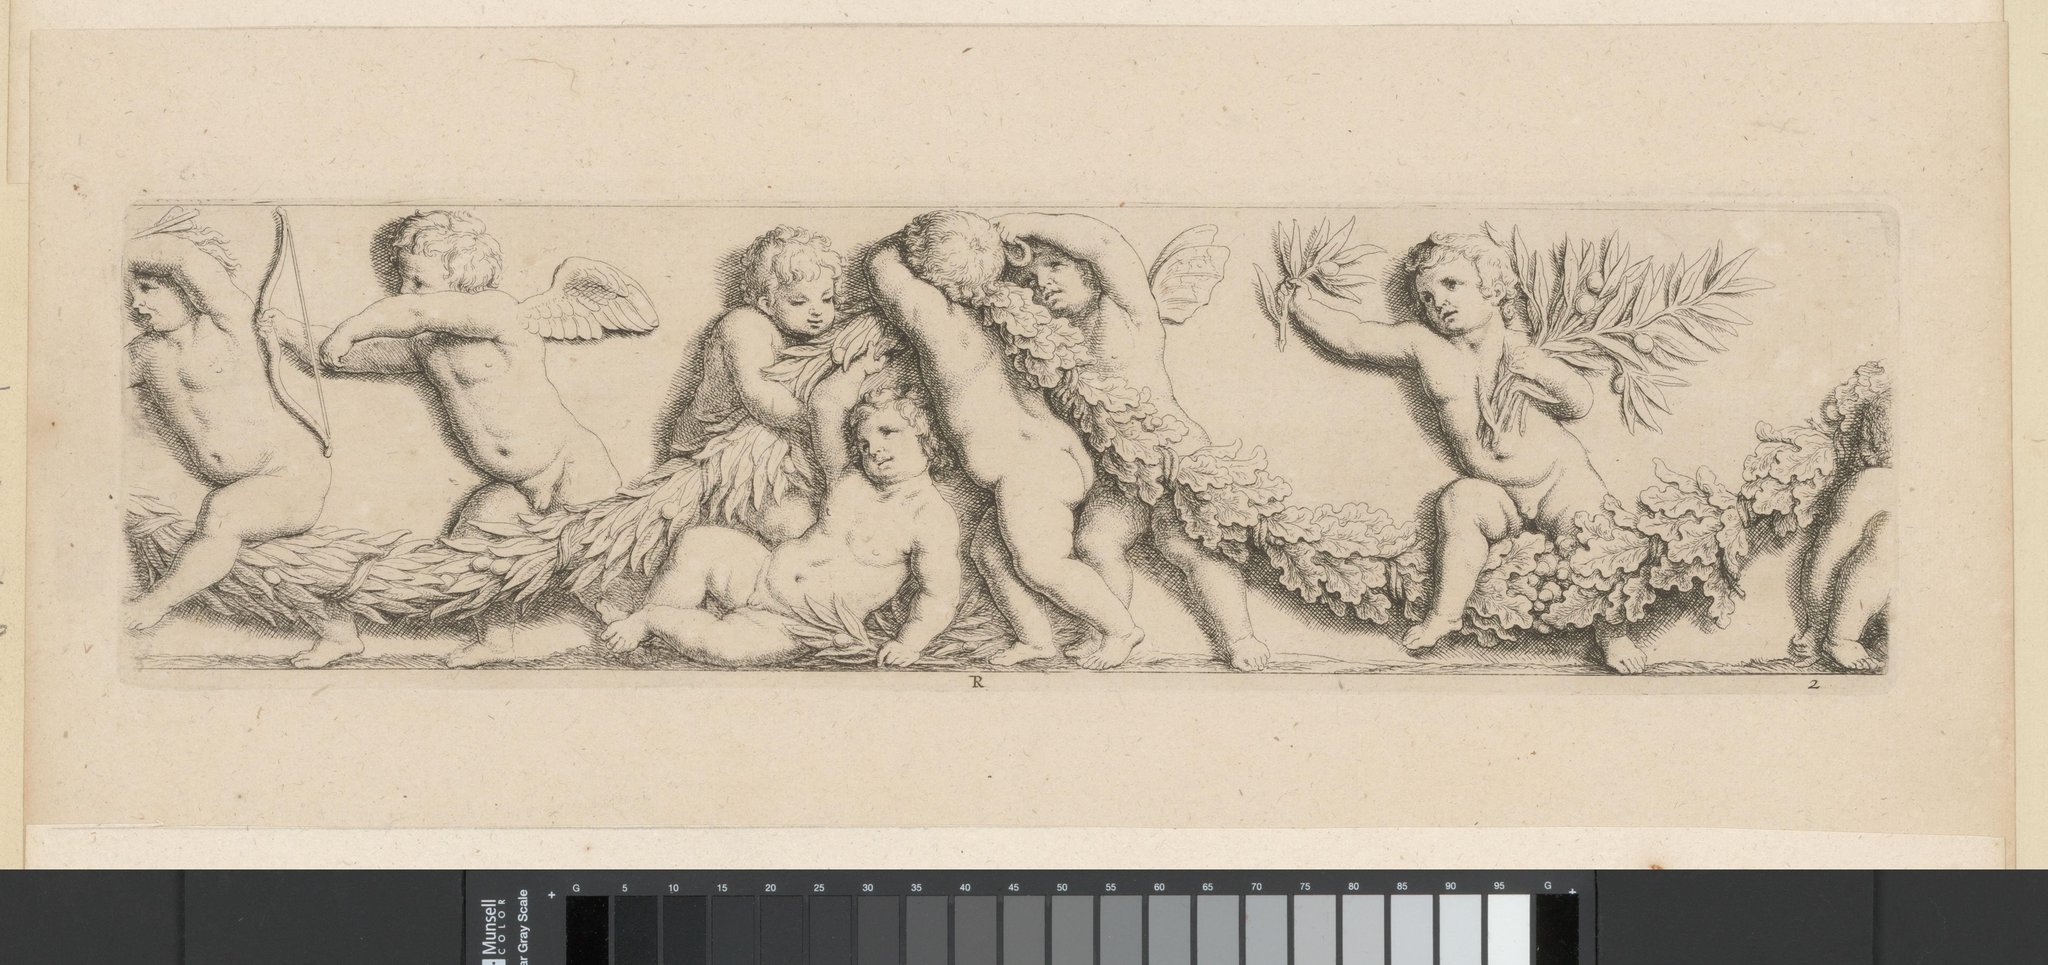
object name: print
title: Deel van fries op schouw in Vroedschapskamer van het Stadhuis op de Dam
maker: hubert quellinus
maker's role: print maker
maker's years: 1619-1687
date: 1663-1668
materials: paper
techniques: engraving, etching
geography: amsterdam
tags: strife between virtues and vices, psychomachy, townhall, allegory, personification of good government, cupids: 'amores', 'amoretti', 'putti'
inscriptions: collector's mark: ‘16,85’ Lugt 1641b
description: Prent gebruikt in: Secunca pars Praecipuarum effigierum ac ornamentorum amplissime Curiae Amstelrodamensis maiori ex parte in cadido marmore effectorum per Artum Quellinium eiusdem Civitatis Statuarium / Het tweede deel Van de voornaemste Statuen ende Cieraten van 't konst-rijcke Stadt-huys van Amstelredam 'tmeeste in Marmer gemaeckt door Artus Quellinus Beelthouwer der voorseyde Stadt. Amsterdam: Artus Quellinus (I), 1663. Zie RP-P-AO-22-2-1 voor bijhorende titelpagina. Zie RP-P-AO-22-2-2 voor bijhorend register. Zie RP-P-AO-22-2A, RP-P-AO-22-2B, RP-P-AO-22-2C-1, RP-P-AO-22-2C-2, RP-P-AO-22-2C-3, RP-P-AO-22-2C-4, RP-P-AO-22-2D-1, RP-P-AO-22-2D-2, RP-P-AO-22-2D-3, RP-P-AO-22-2E-1, RP-P-AO-22-2E-2, RP-P-AO-22-2E-3, RP-P-AO-22-2E-4, RP-P-AO-22-2F-1, RP-P-AO-22-2F-2, RP-P-AO-22-2F-3, RP-P-AO-22-2G, RP-P-AO-22-2H, RP-P-AO-22-2I, RP-P-AO-22-2K, RP-P-AO-22-2L, RP-P-AO-22-2M, RP-P-AO-22-2N, RP-P-AO-22-2O-1, RP-P-AO-22-2O-2, RP-P-AO-22-2O-3, RP-P-AO-22-2O-4, RP-P-AO-22-2O-5, RP-P-AO-22-2O-6, RP-P-AO-22-2O-7, RP-P-AO-22-2P-1, RP-P-AO-22-2P-2, RP-P-AO-22-2Q-1, RP-P-AO-22-2Q-2, RP-P-AO-22-2Q-3, RP-P-AO-22-2R-1, RP-P-AO-22-2R-3, RP-P-AO-22-2S, RP-P-AO-22-2T-1, RP-P-AO-22-2T-2, RP-P-AO-22-2T-3, RP-P-AO-22-2T-4, RP-P-AO-22-2V-1, RP-P-AO-22-2V-2, RP-P-AO-22-2W-1, RP-P-AO-22-2W-2, RP-P-AO-22-2X-1, RP-P-AO-22-2X-2 en RP-P-AO-22-2X-3 voor andere prenten uit deze publicatie. Zelfde staat van prent ook gebruikt in: Secunca pars Praecipuarum effigierum ac ornamentorum amplissime Curiae Amstelrodamensis maiori ex parte in cadido marmore effectorum per Artum Quellinium eiusdem Civitatis Statuarium / Het tweede deel Van de voornaemste Statuen ende Cieraten van 't konst-rijcke Stadt-huys van Amstelredam 'tmeeste in Marmer gemaeckt door Artus Quellinus Beelthouwer der voorseyde Stadt. Amsterdam: Frederik de Wit, 1668. Latere staat van prent ook gebruikt in: Architecture peinture et sculpture de la Maison de Ville d'Amsterdam, representee en CIX. figures en taille-douce (…). Amsterdam: David Mortier, 1719. En in: Architecture peinture et sculpture de la Maison de Ville d'Amsterdam, representee en CIX. figures en taille-douce (…). Amsterdam: Gerard Valck, 1719. En in: Bouw schilder en beeldhouwkonst, van het Stadhuis te Amsteldam, vertoont in CIX figuuren (…). Amsterdam: Covens & Mortier & Covens Jr., s.a. (1774-1783).